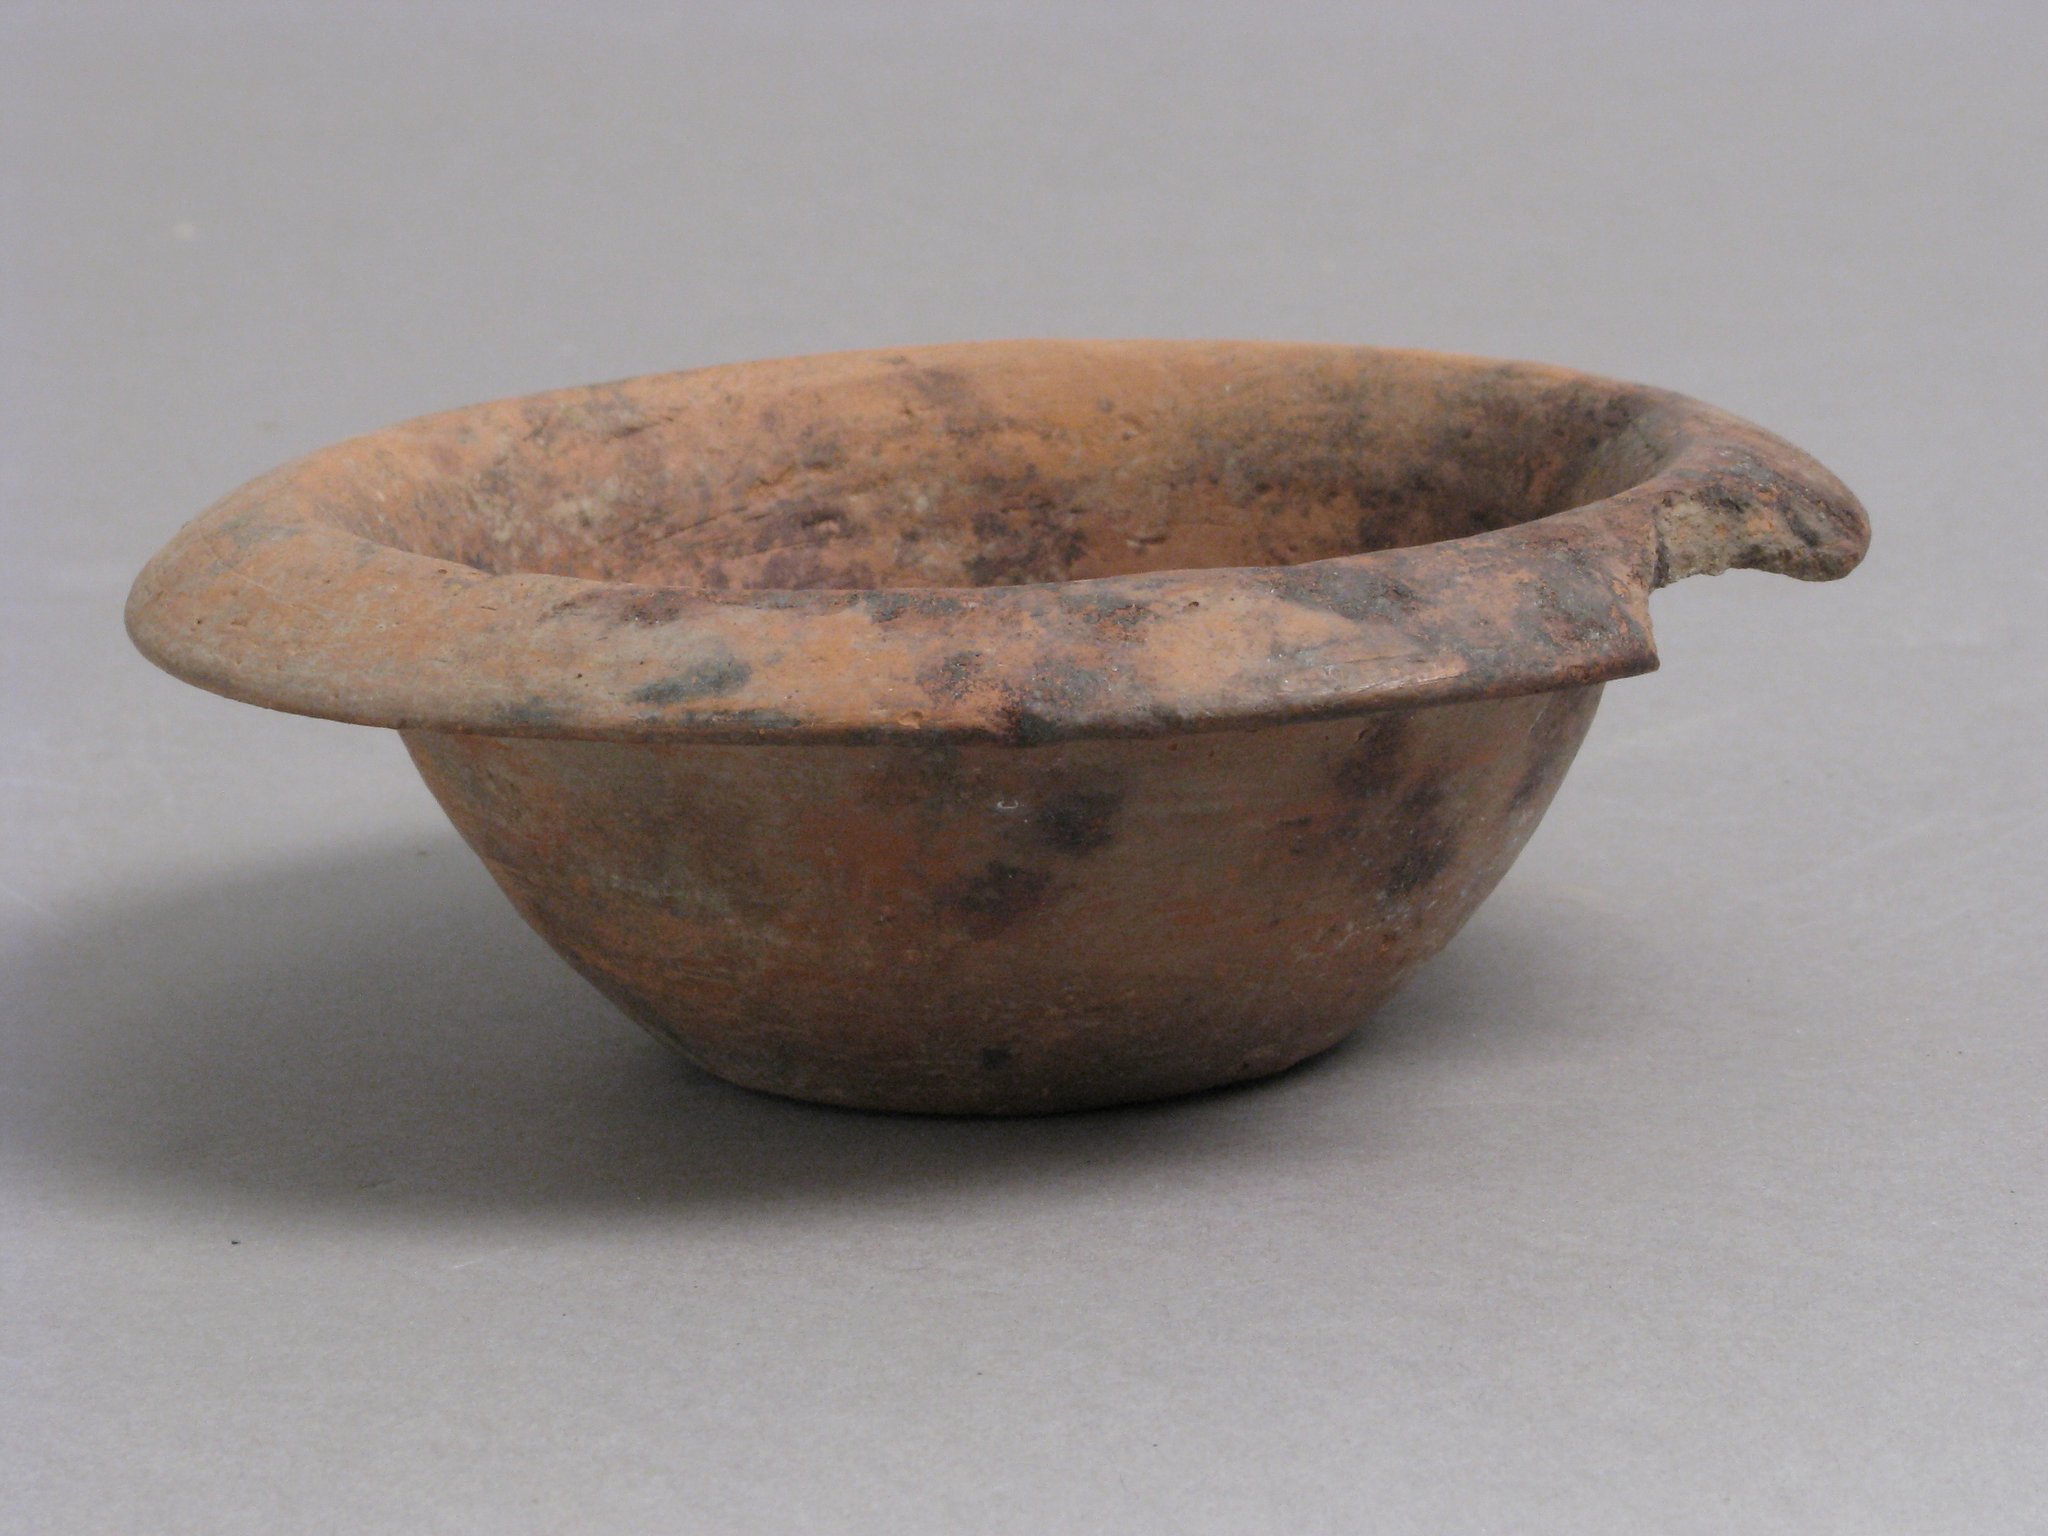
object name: bowl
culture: coptic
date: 301-700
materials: earthenware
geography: egypt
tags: bowls